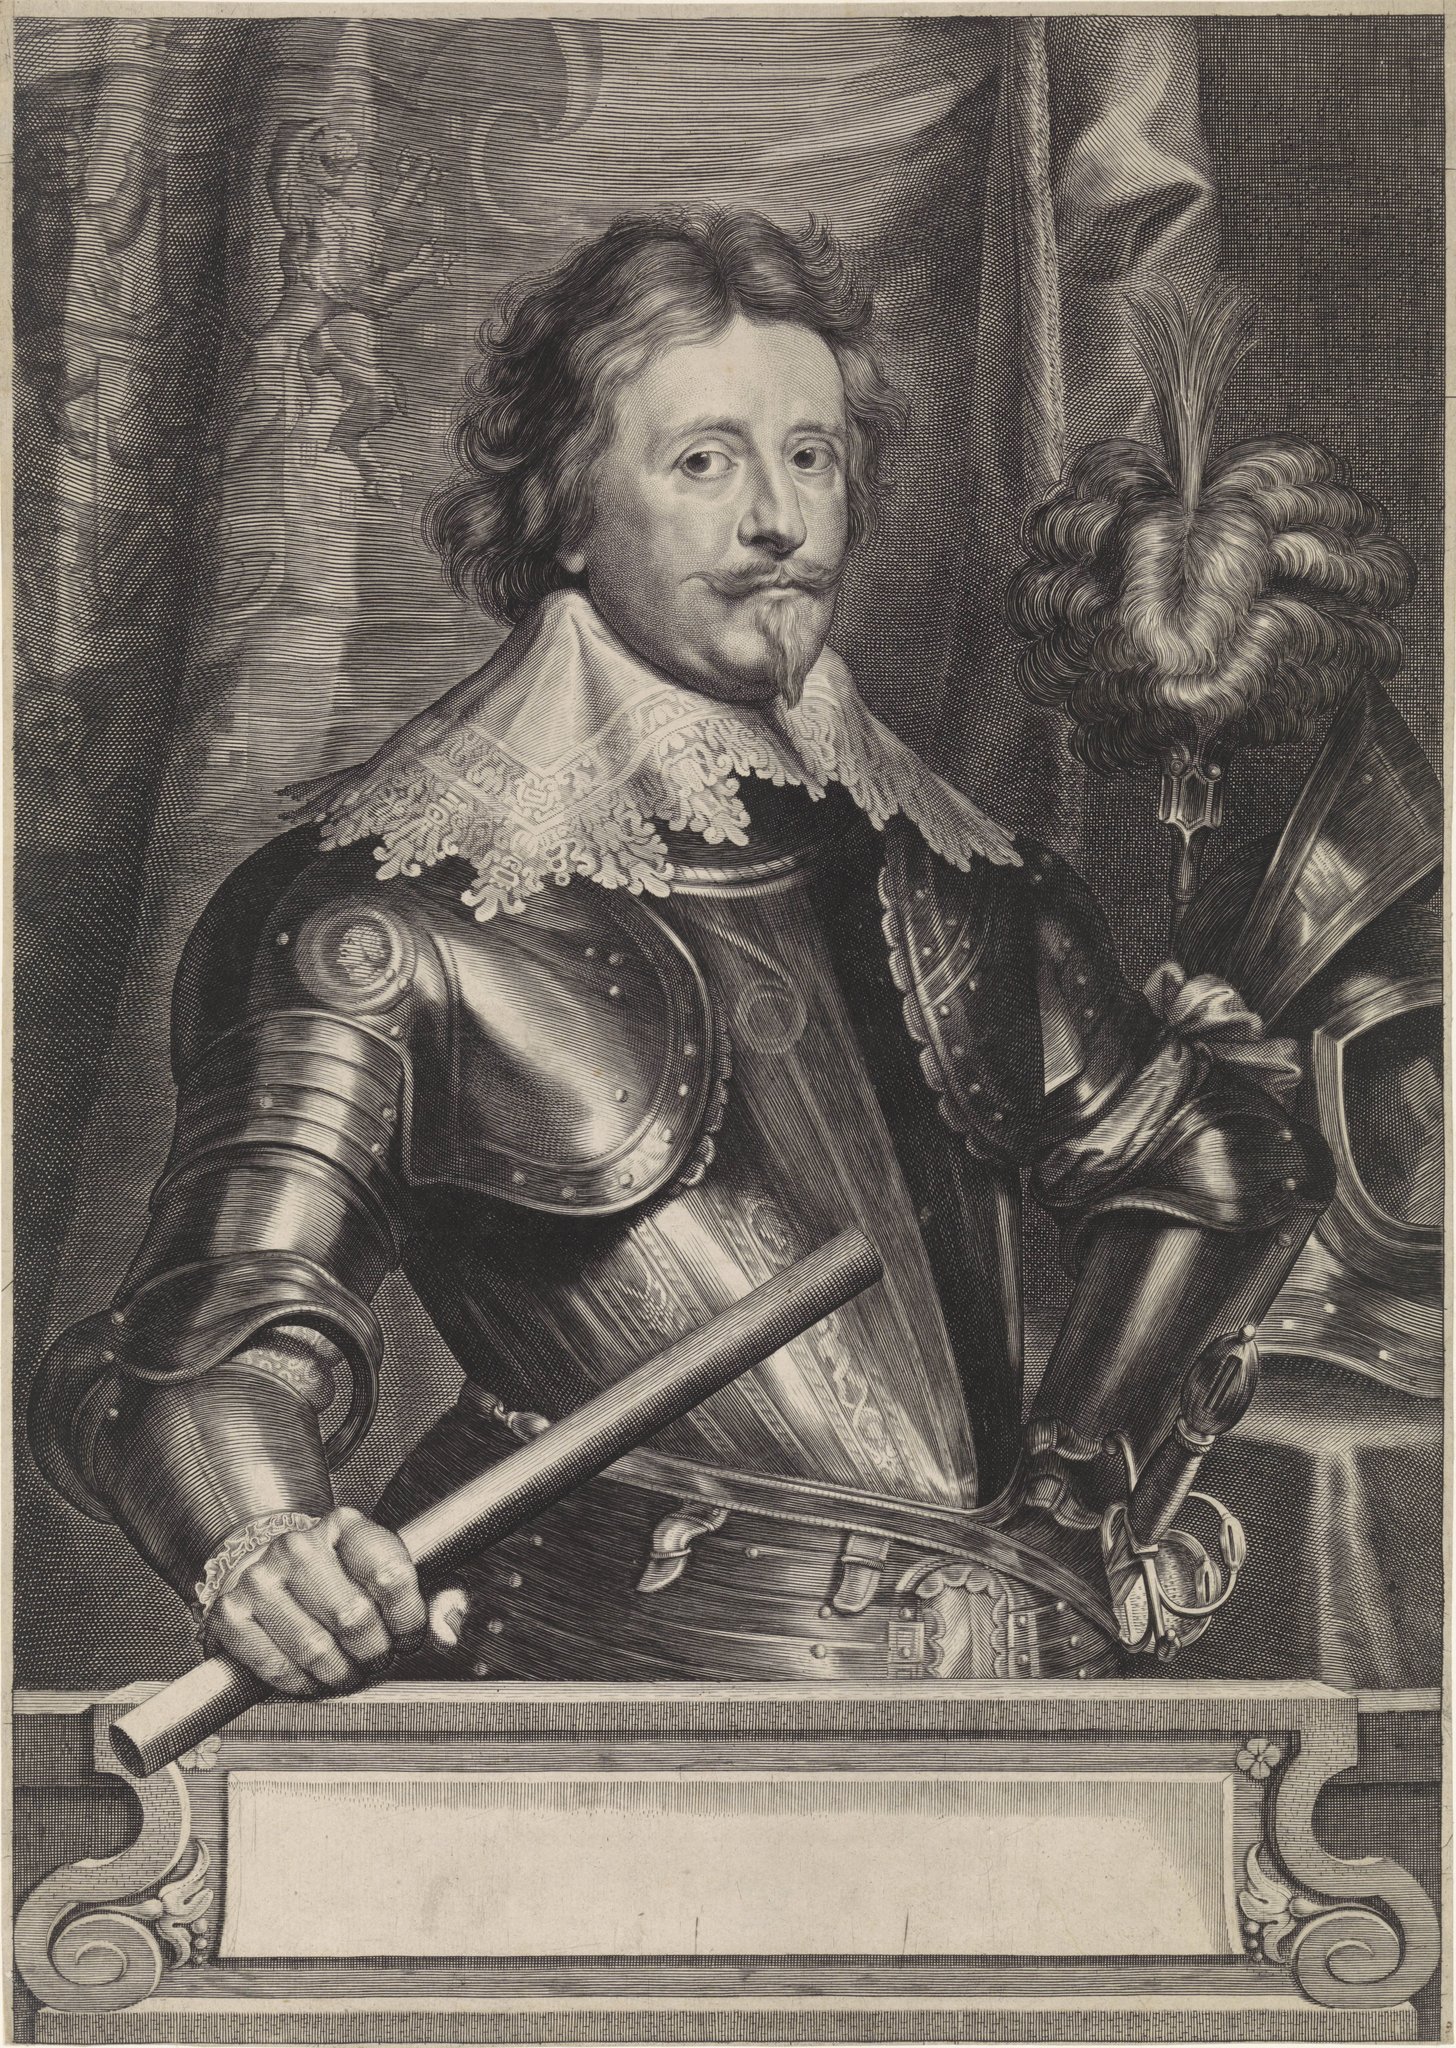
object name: print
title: Portret van Frederik Hendrik, prins van Oranje-Nassau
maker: paulus pontius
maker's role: draughtsman, print maker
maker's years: 1603-1658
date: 1616-1657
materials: paper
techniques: engraving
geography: antwerp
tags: delft, the hague, frederick henry (prince of orange), armour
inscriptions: collector's mark: Lugt 963, collector's mark: Lugt 2228, number: ‘9’, collector's mark